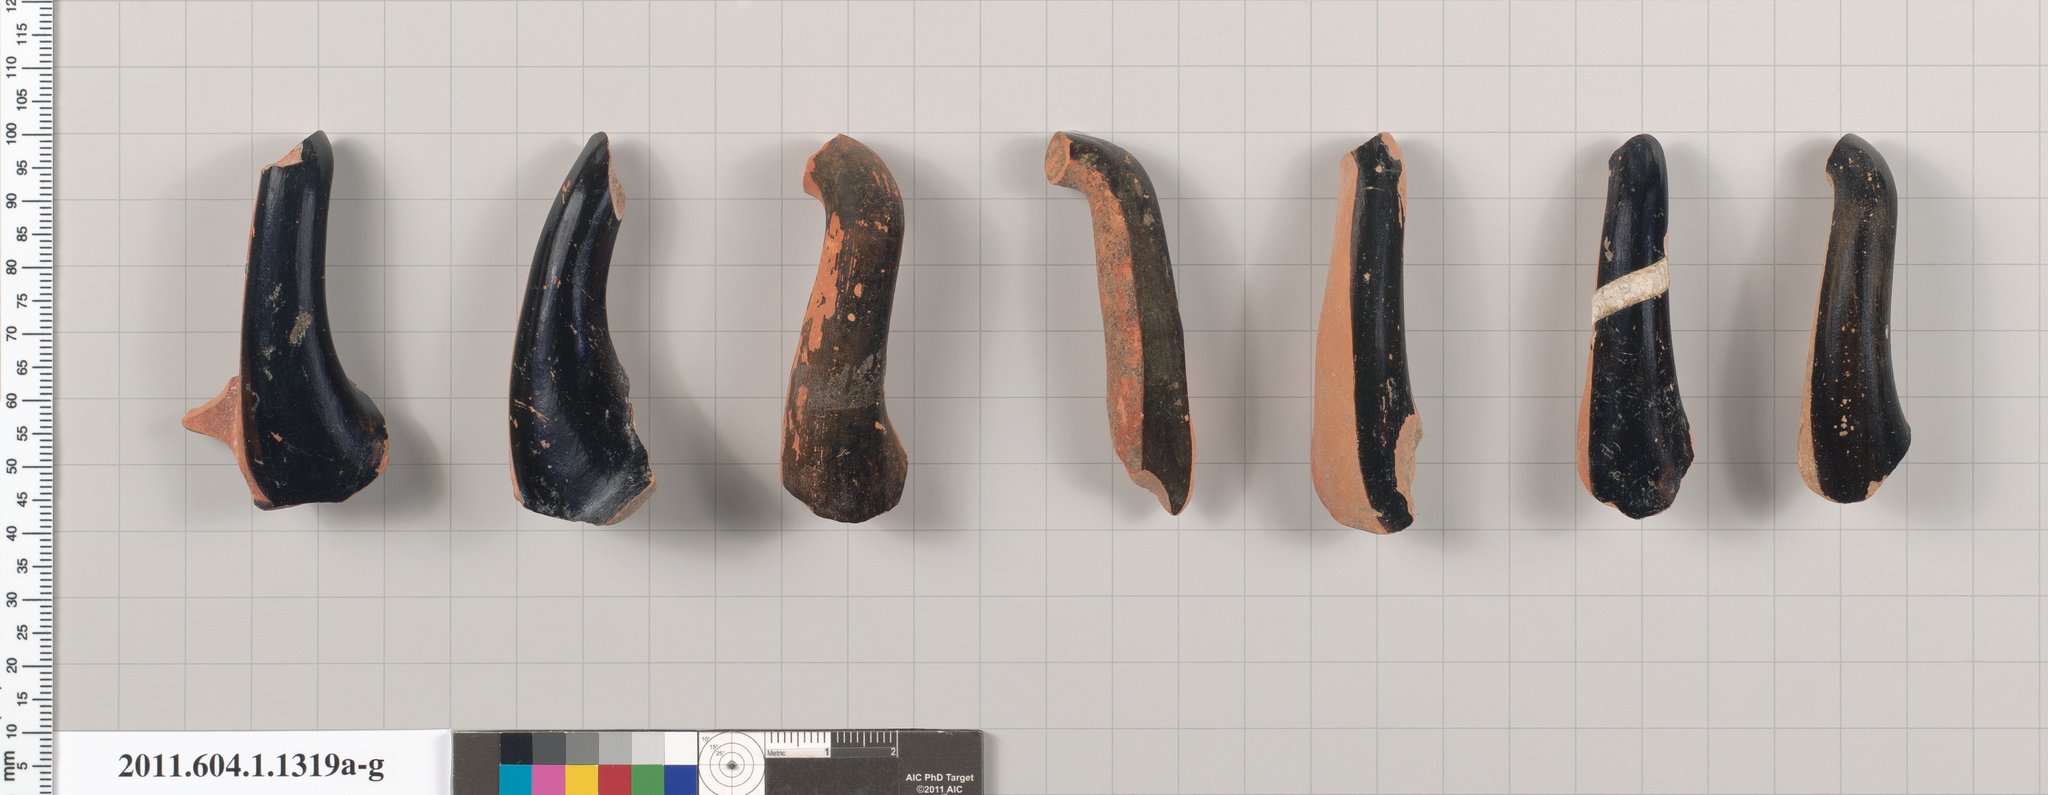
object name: kylix fragment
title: Terracotta fragments of kylikes (drinking cups)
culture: greek, attic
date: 500-401 BCE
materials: terracotta